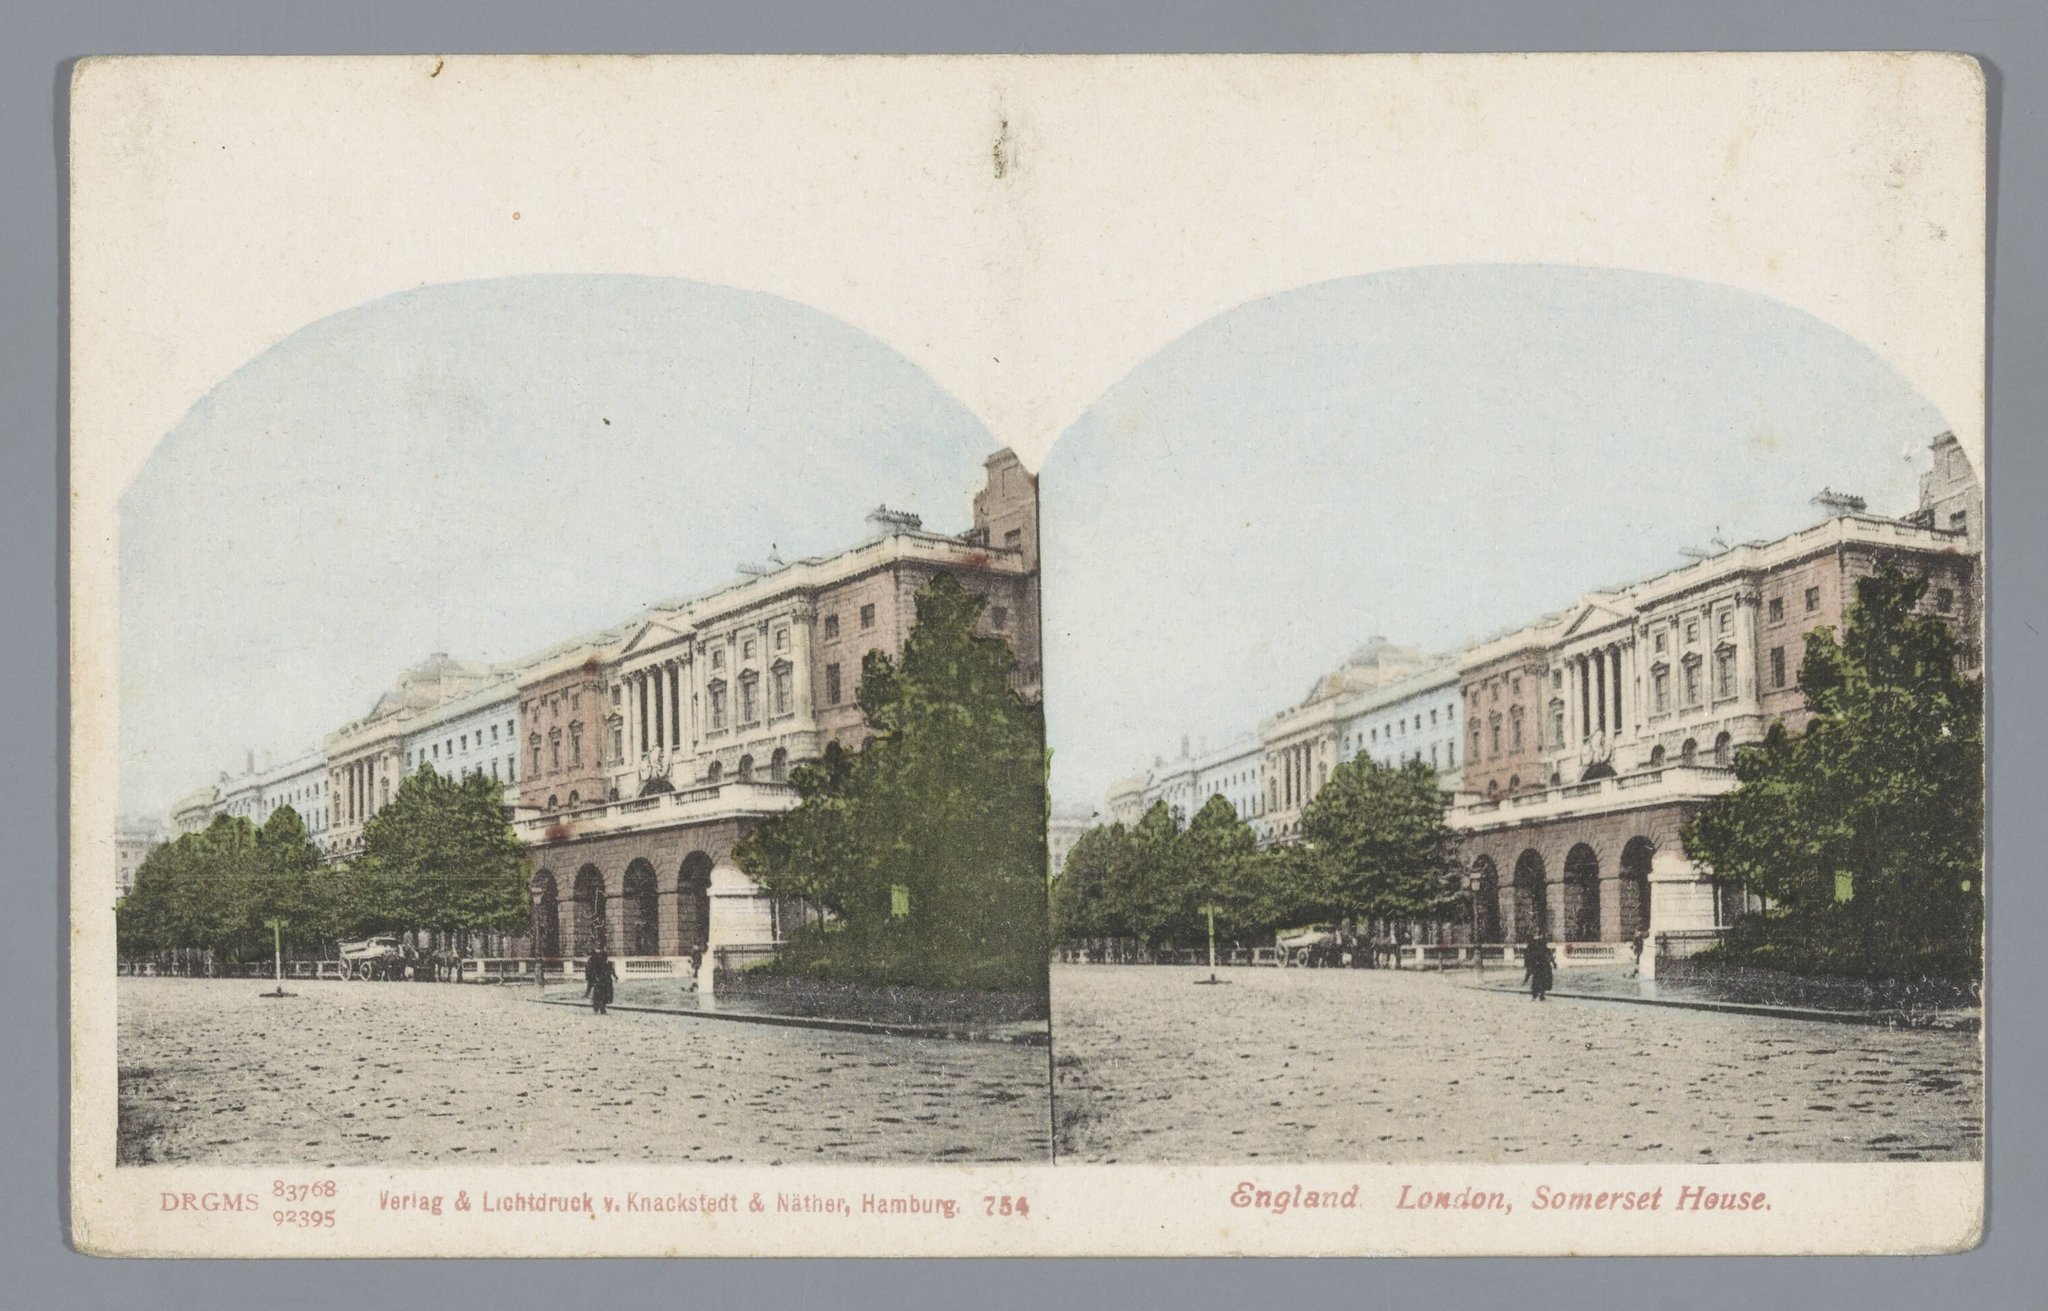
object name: photomechanical print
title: Somerset House in Londen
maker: Anonymous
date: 1889-1905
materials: cardboard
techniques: photograph, hand coloring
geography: london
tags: edifice, e.g.: public building, department store, london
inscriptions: inscription: ‘DRGMS 83768/ 92395’, inscription: ‘Postkarte’, number: ‘754’